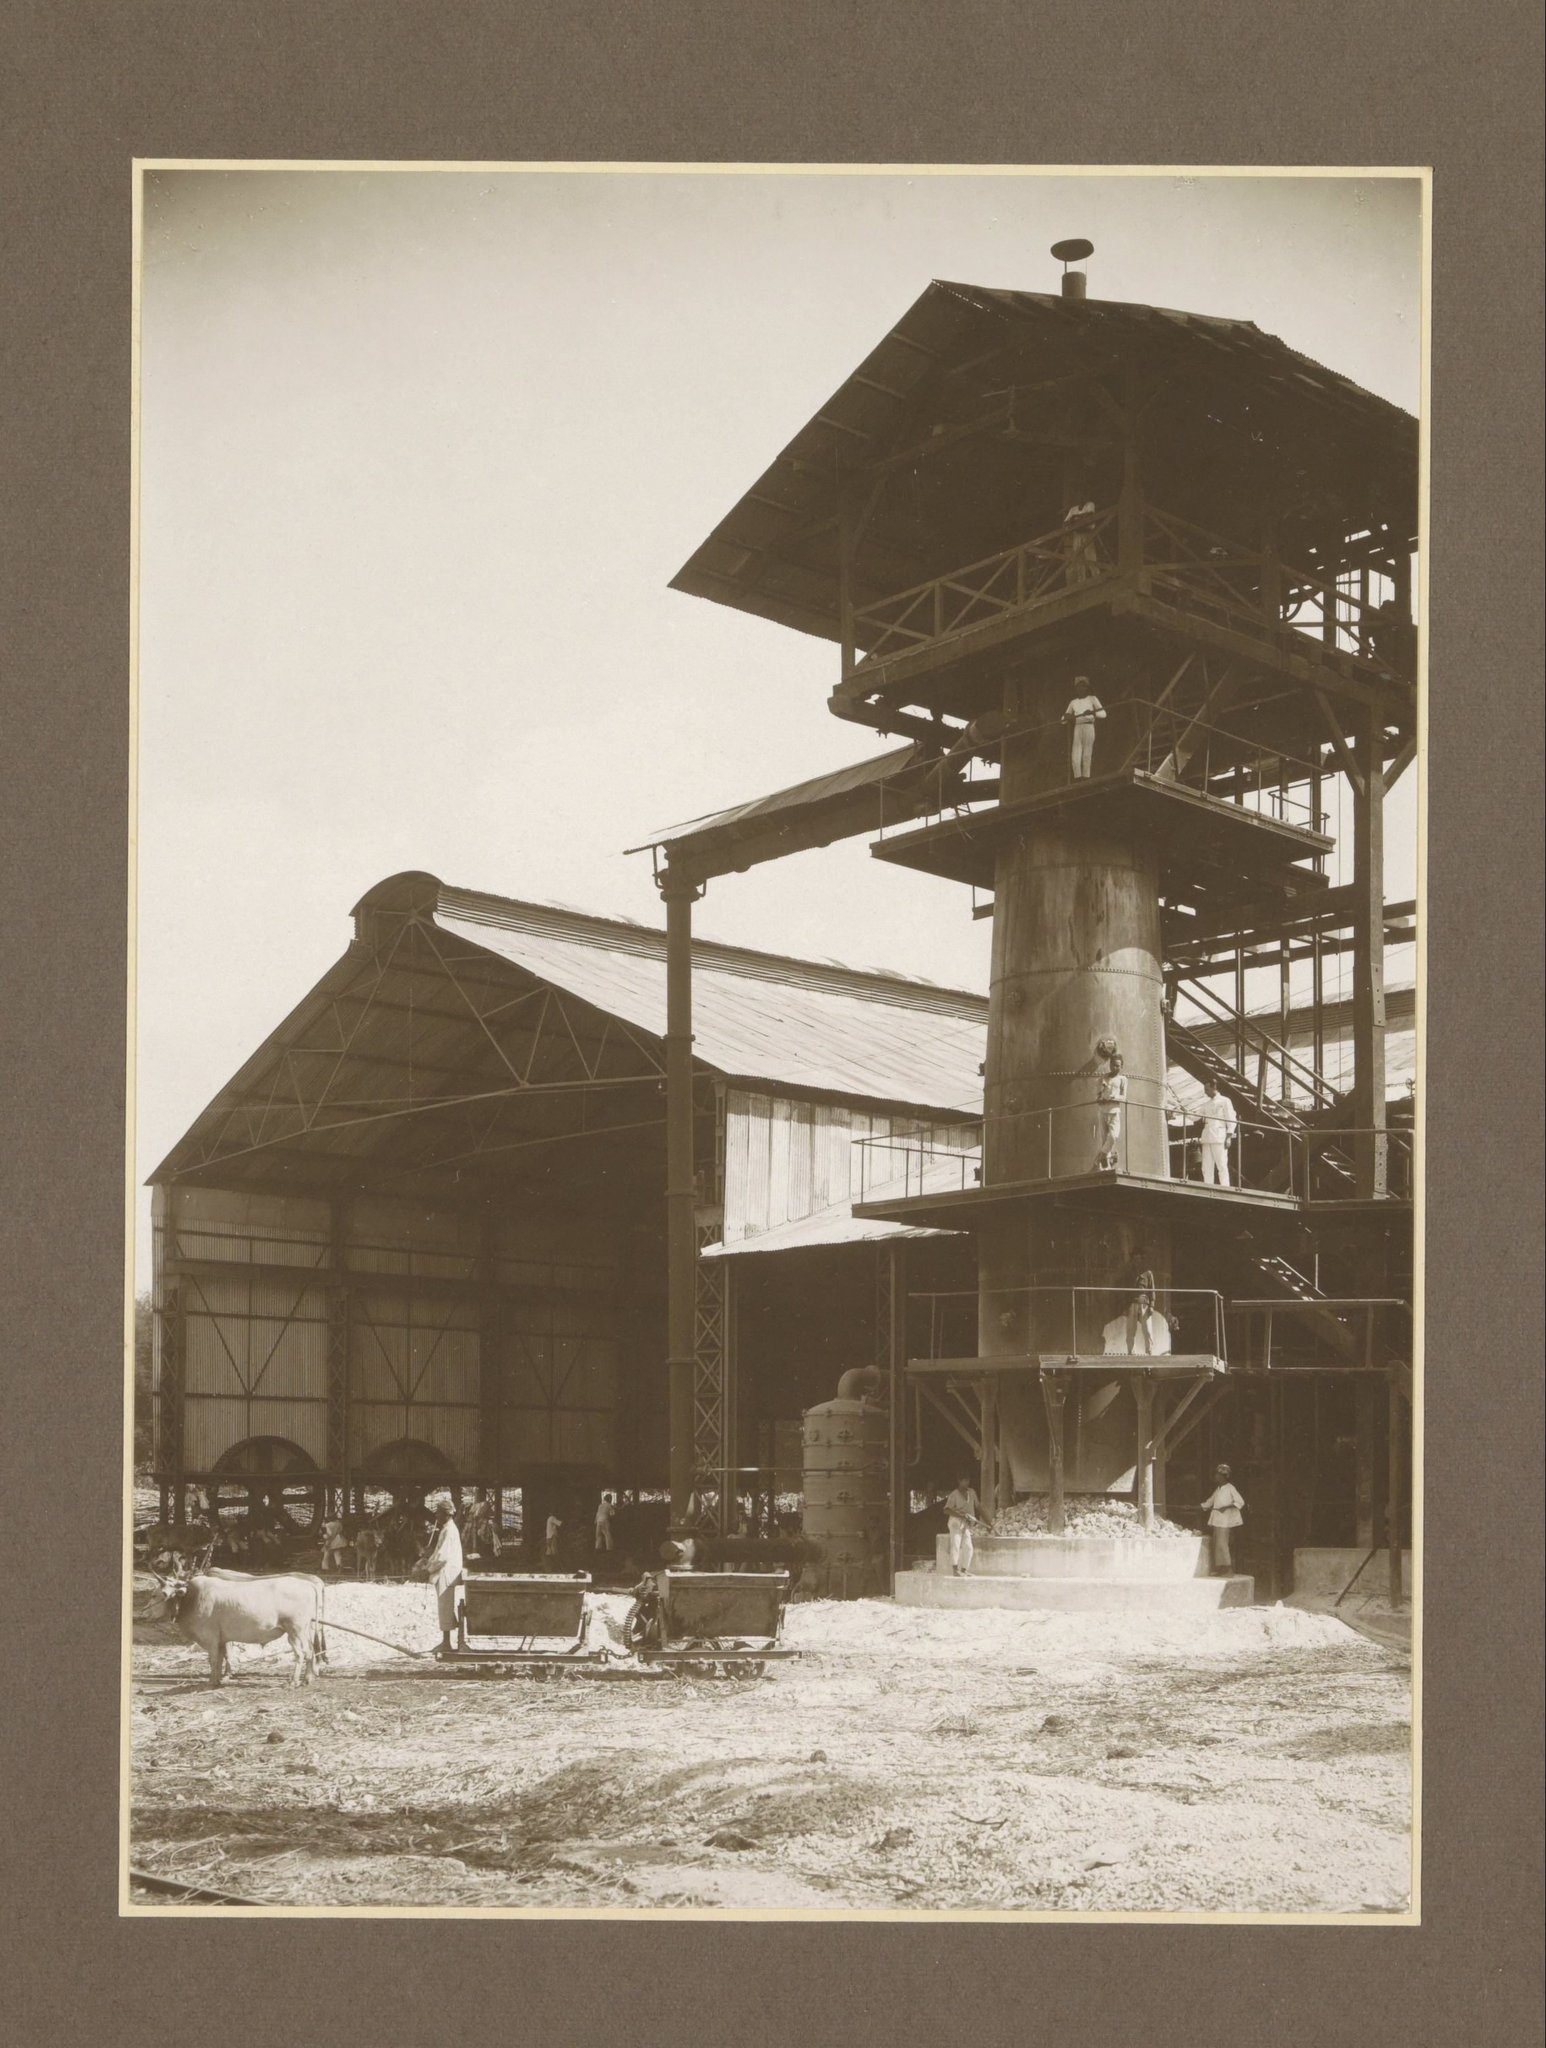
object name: photograph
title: Kalkoven en werknemers van suikerfabriek Boedoeran in Sidoarjo op Java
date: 1925-1930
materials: cardboard, paper, photographic support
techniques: gelatin silver print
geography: sidoarjo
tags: plantation, working class, labourers, lime-burner, plants and herbs: sugarcane, sugar, dutch east indies, the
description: Onderdeel van Fotoalbum met opnames van vier suikerfabrieken op Java.